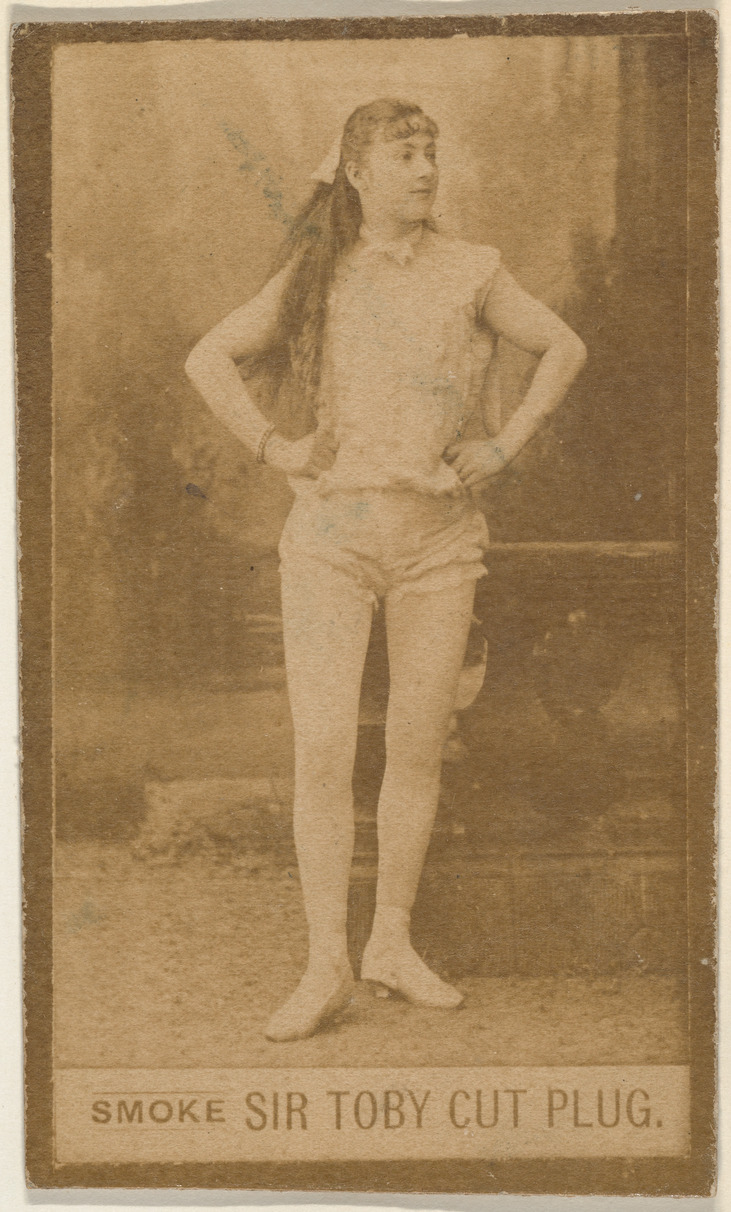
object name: photograph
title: Actress standing with hands on hips, from the series Actresses (N673), promoting Sir Toby Cut Plug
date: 1888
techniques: albumen silver print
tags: portraits,women,actresses